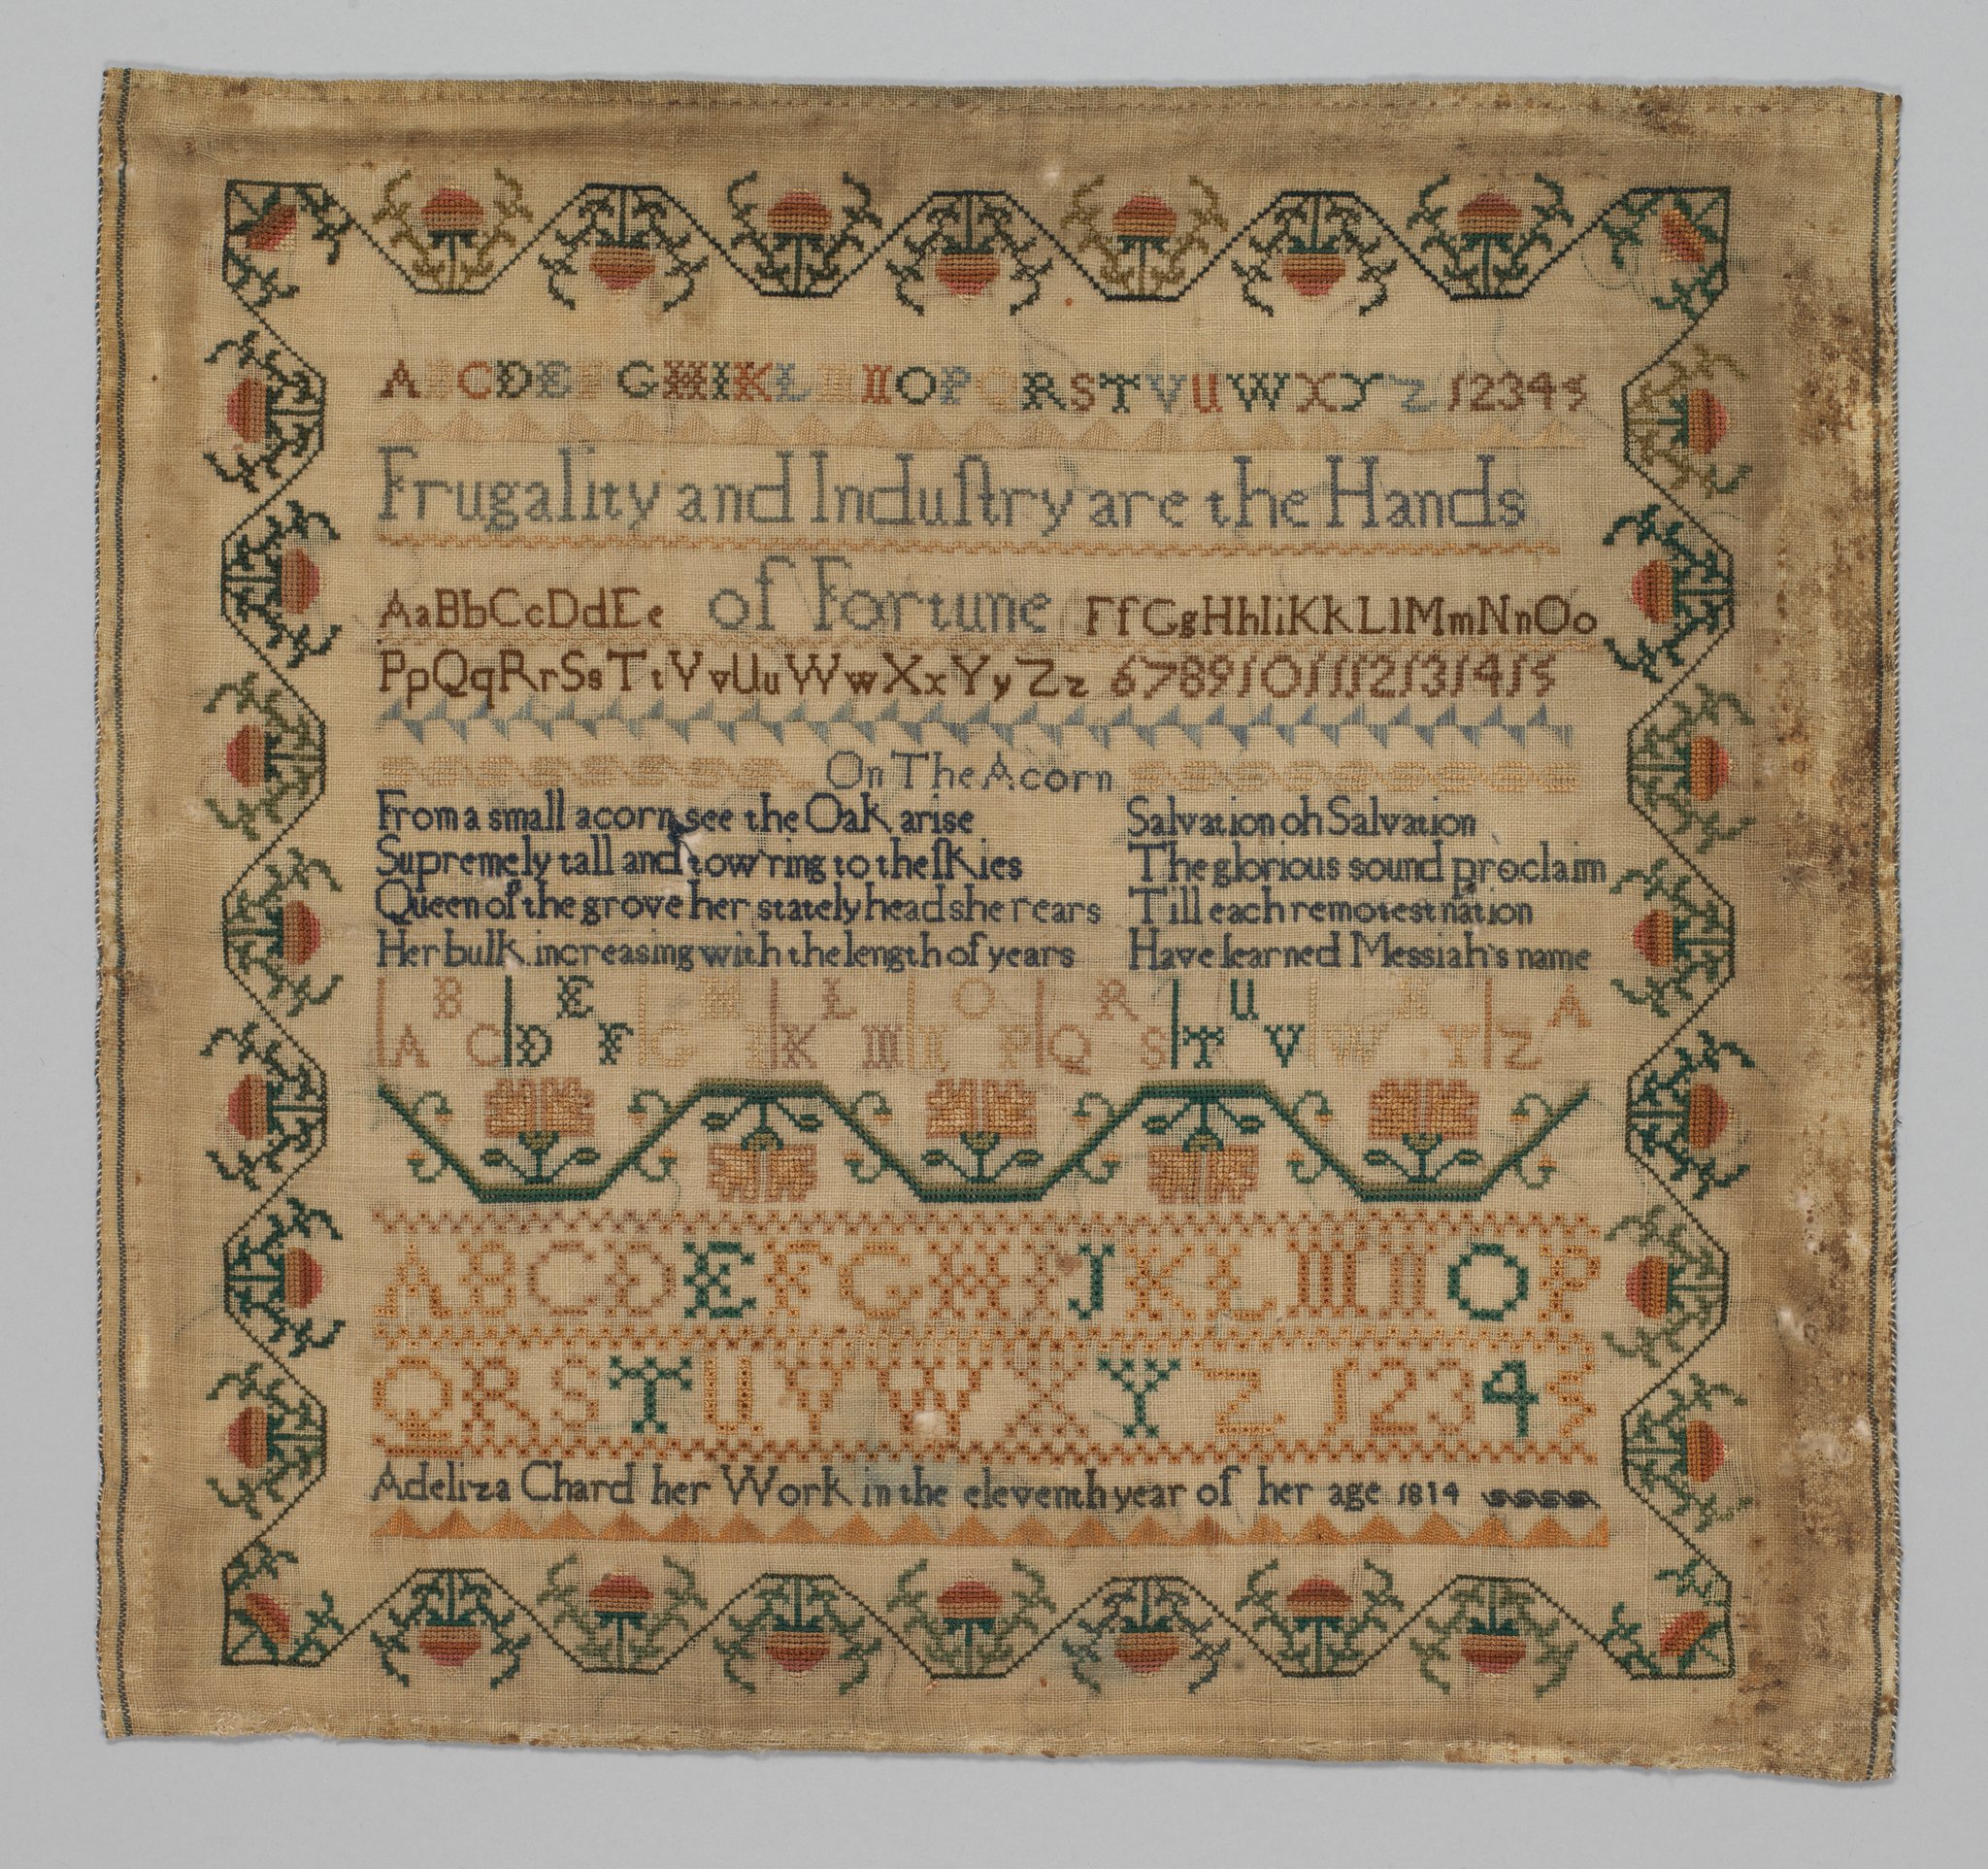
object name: sampler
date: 1814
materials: canvas, silk, wool